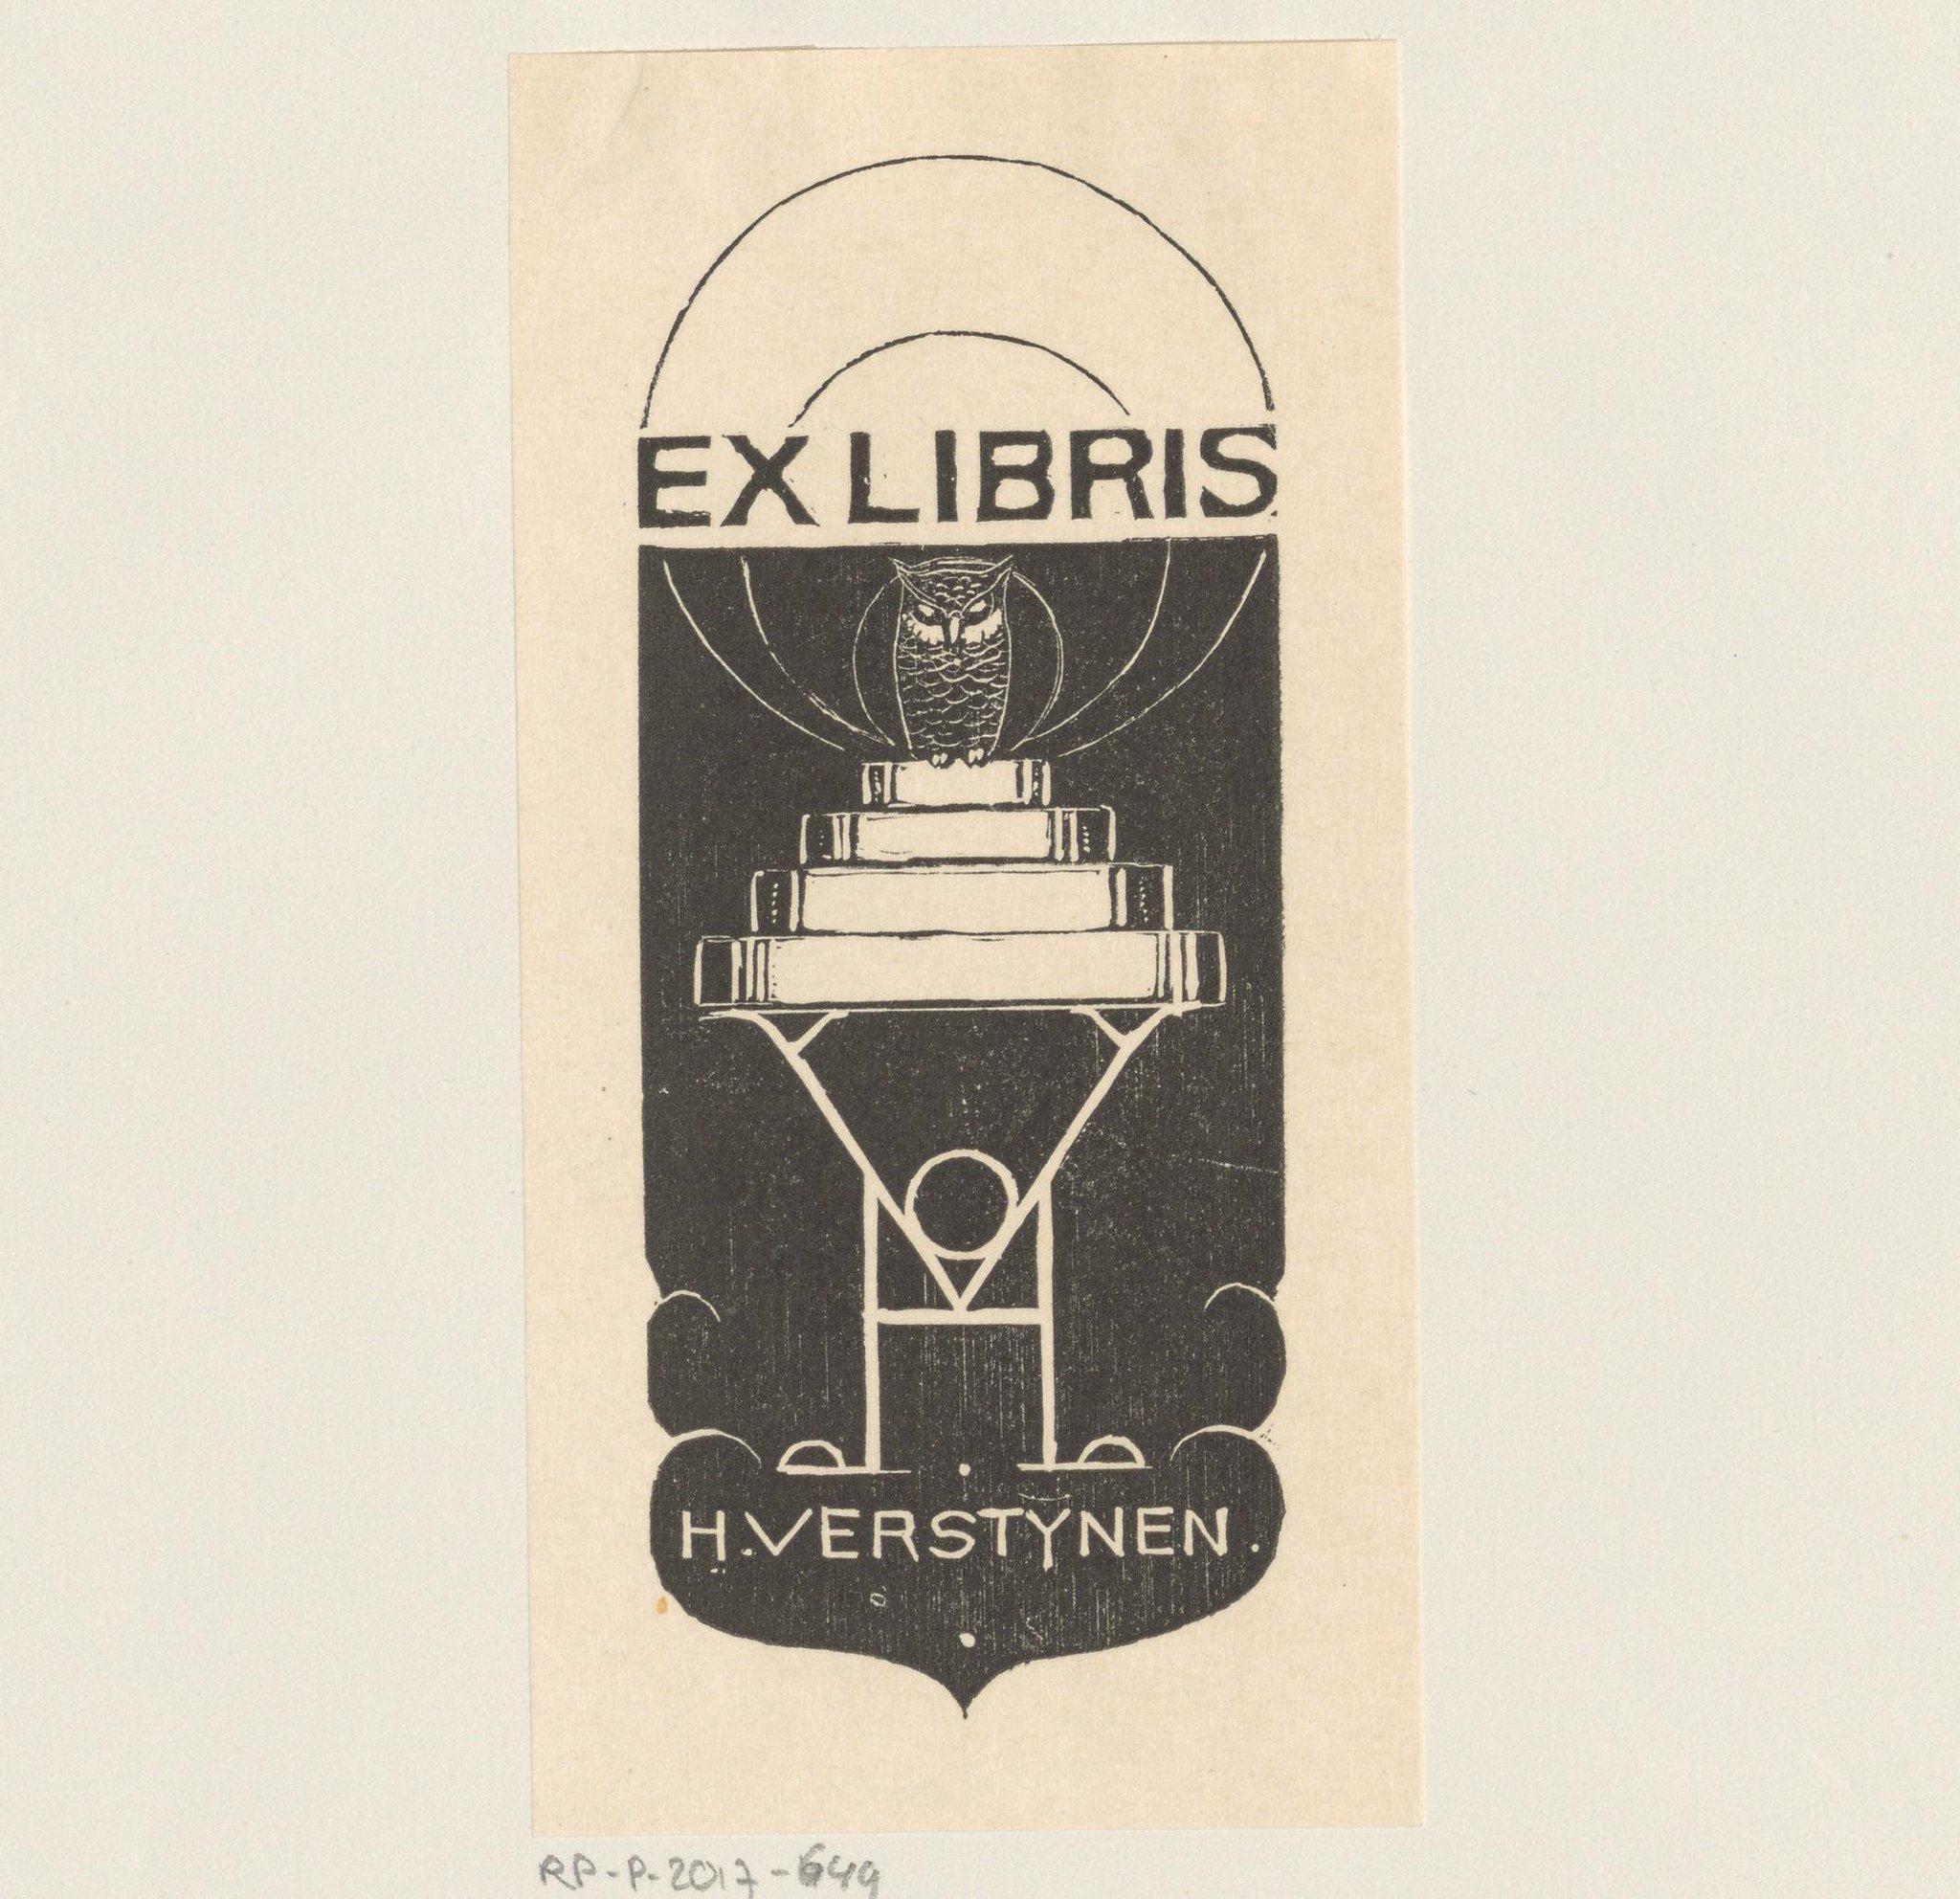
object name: bookplate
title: Ex libris van H. Verstijnen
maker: henri verstijnen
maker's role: draughtsman, print maker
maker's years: 1882-1940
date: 1892-1940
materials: paper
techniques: engraving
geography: netherlands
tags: print maker, draughtsman, henri verstijnen, book, owls